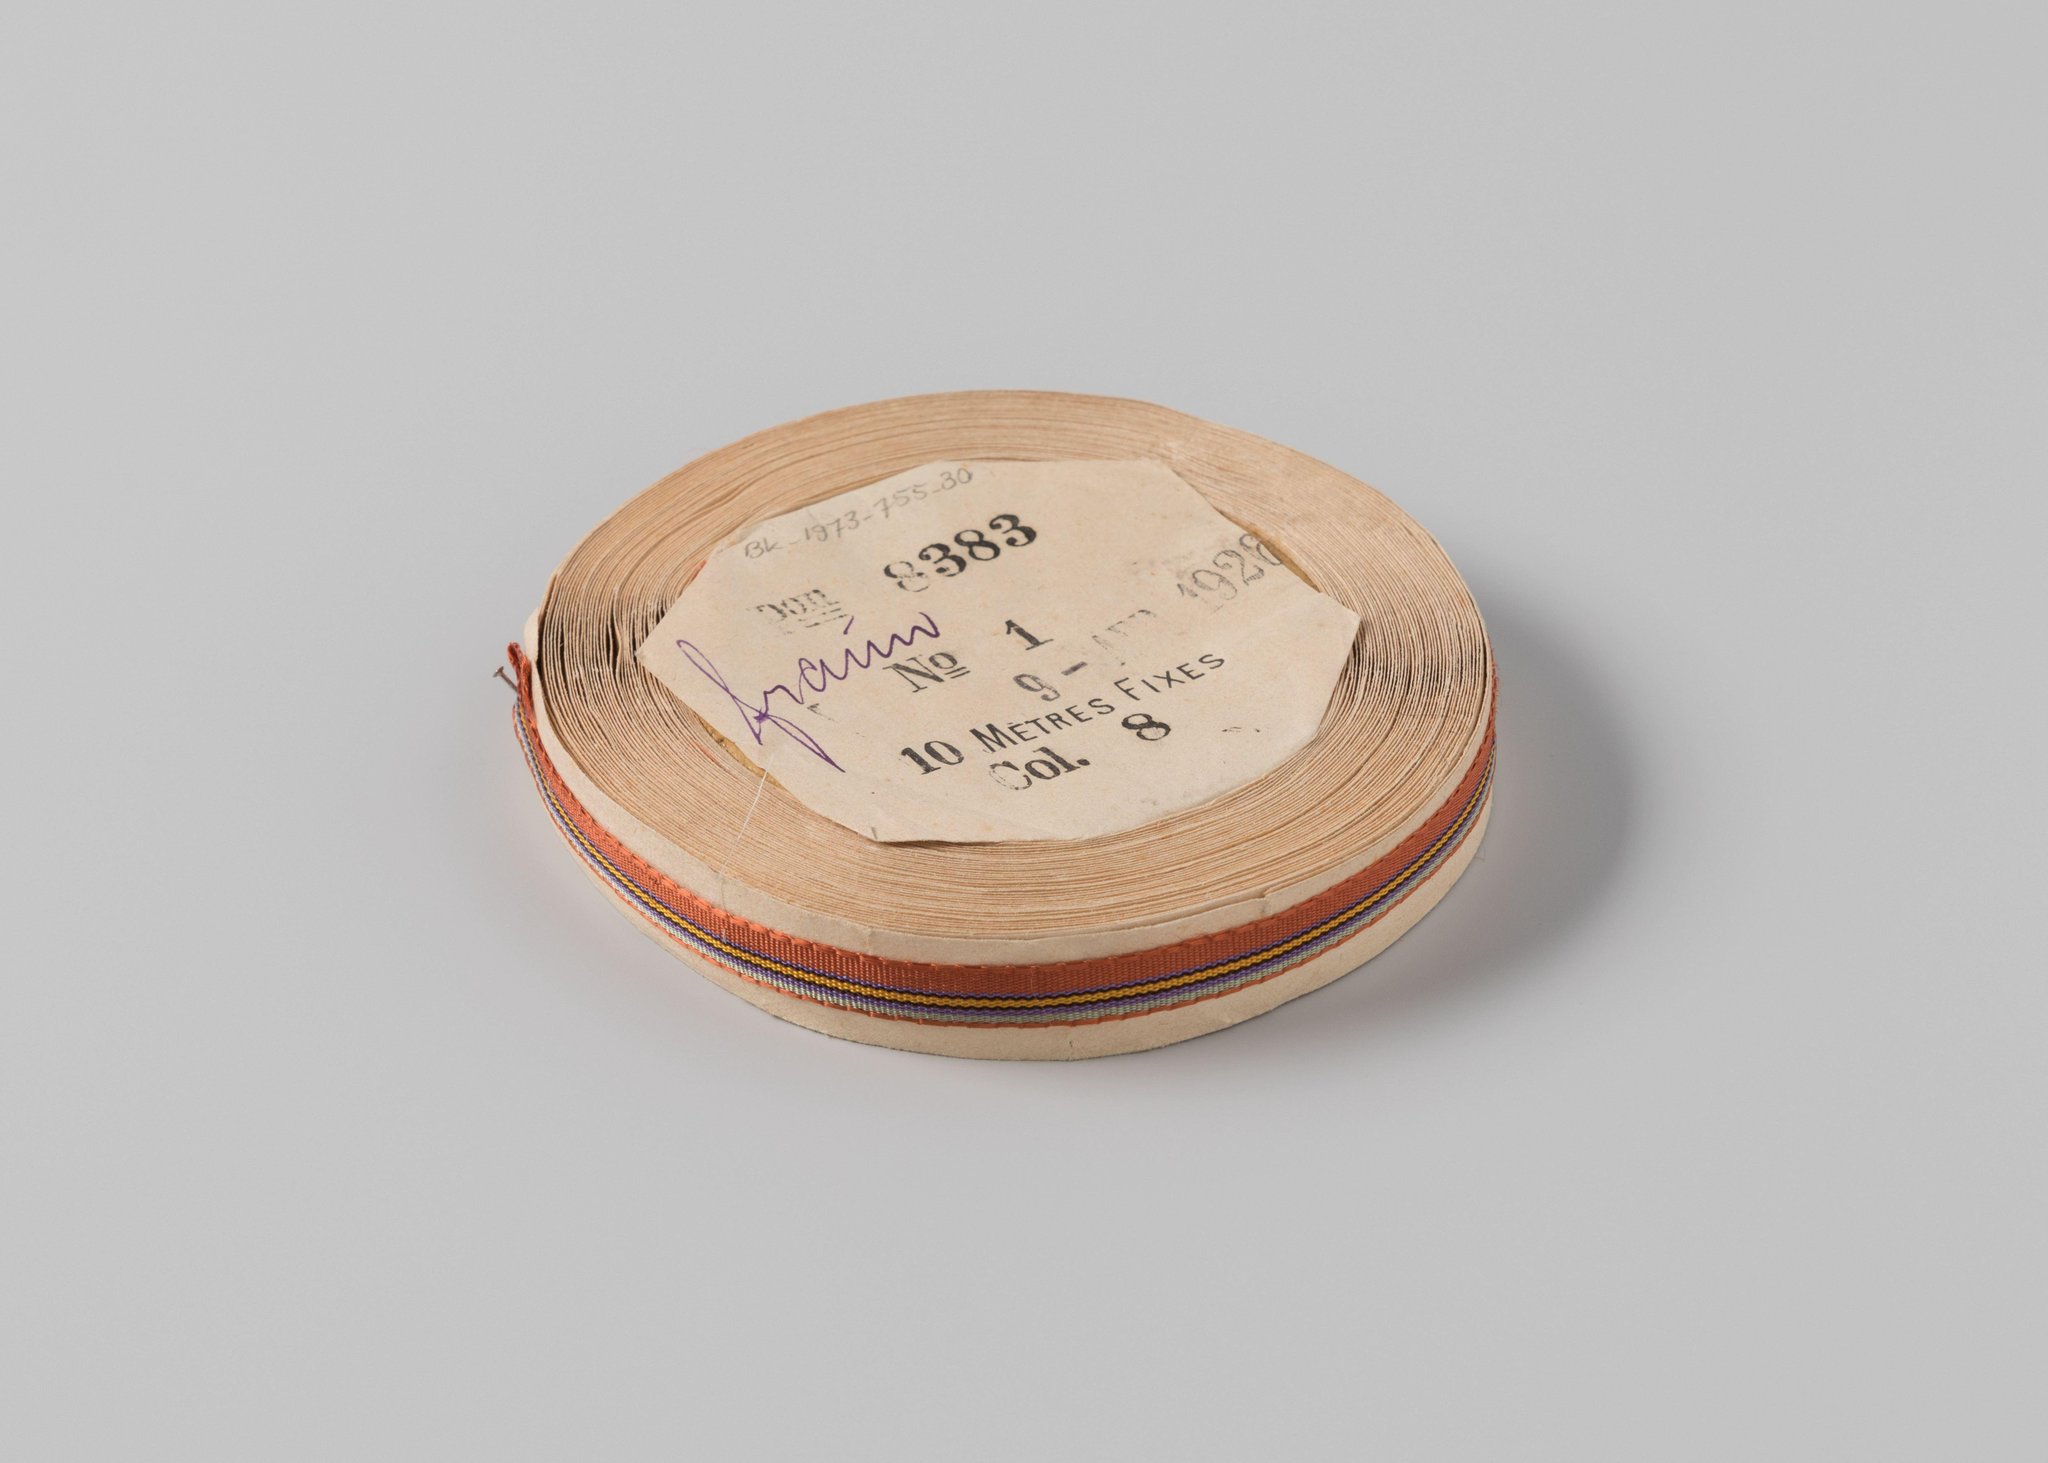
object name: ribbon material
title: Lint op rol, gestreept, bruin met lila, zwart, lichtgroen en oranje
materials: cardboard, paper, textile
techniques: weave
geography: france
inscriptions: stamp: ‘9 - APR. 1926’, number: ‘Pon 8383’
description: Lint op rol, gestreept, bruin met lila, zwart, lichtgroen en oranje.